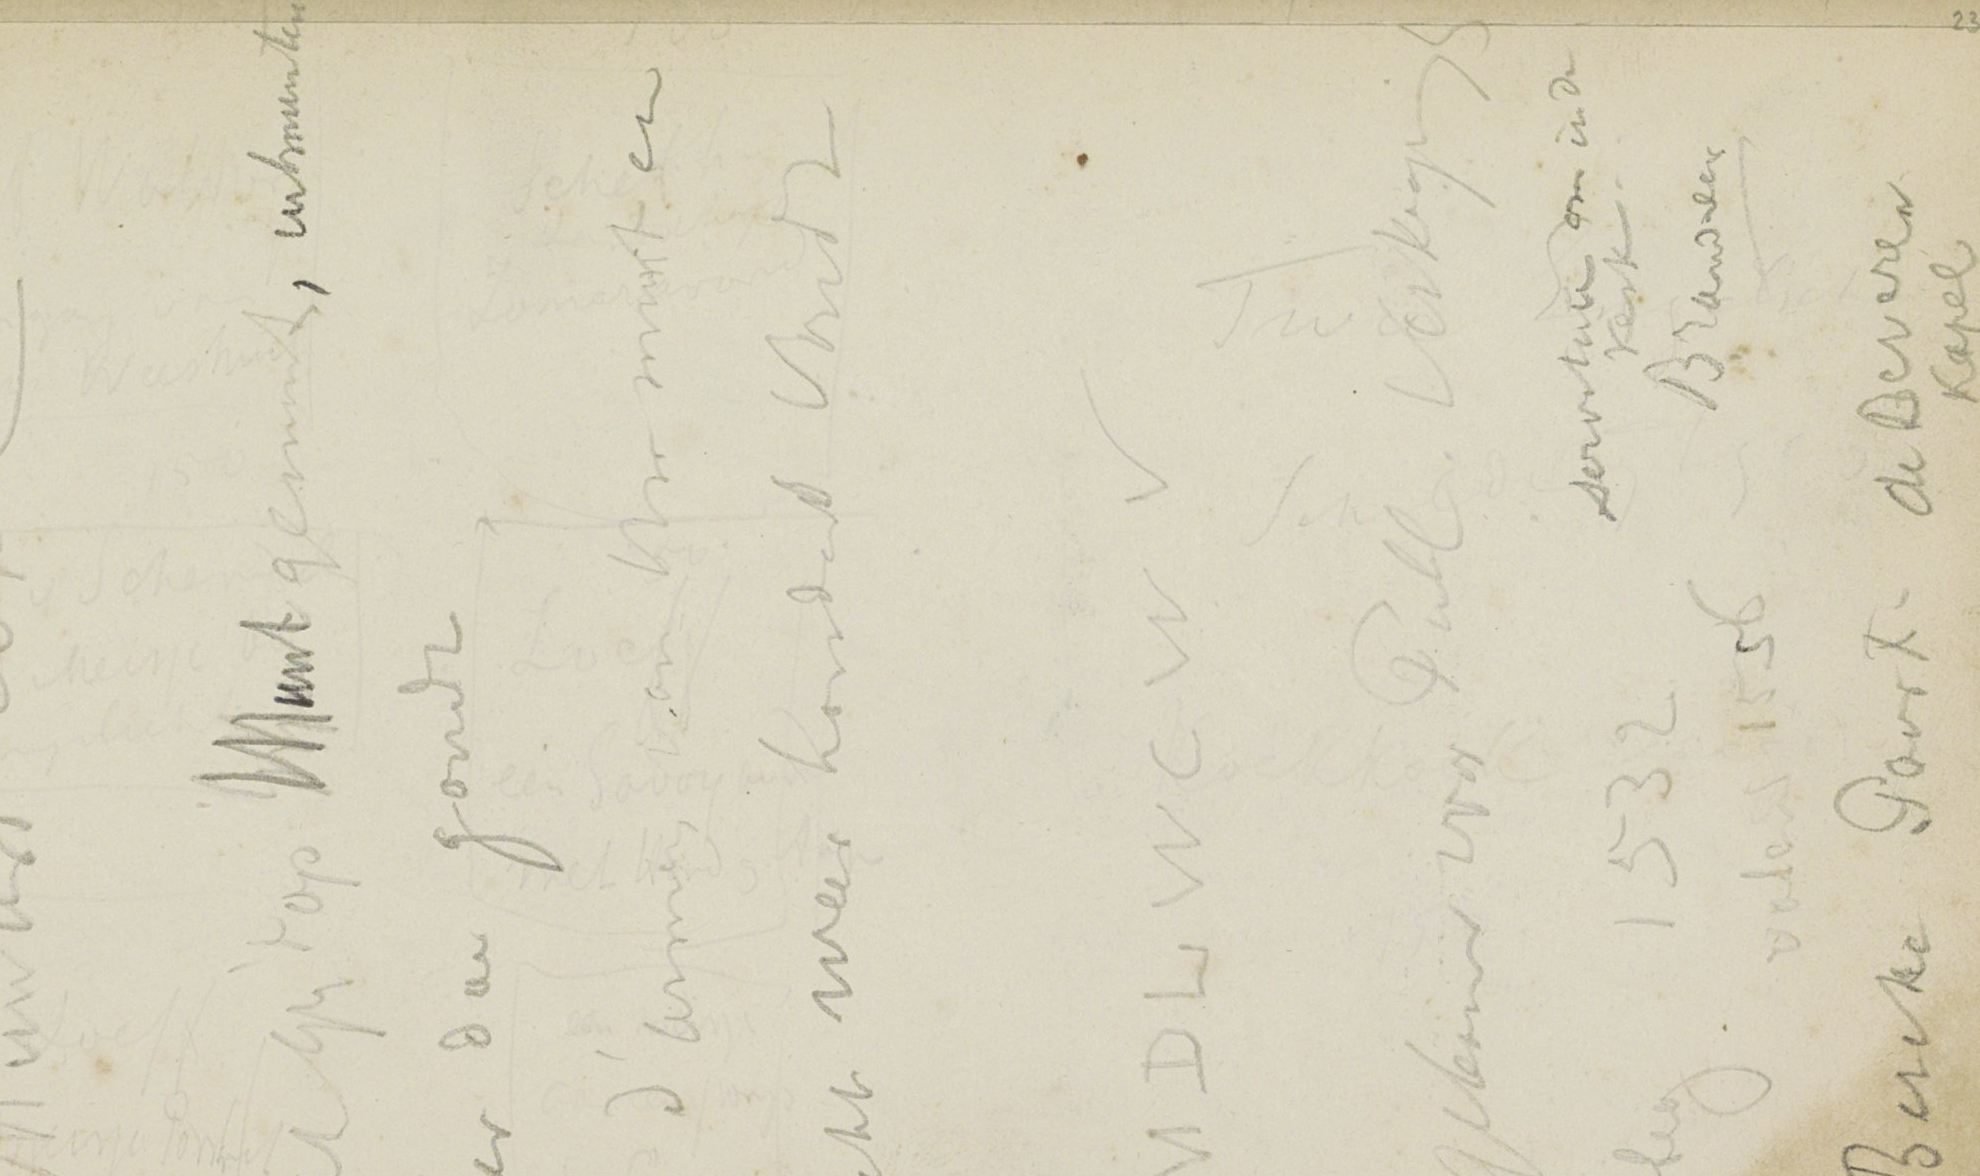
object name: sketchbook leaf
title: Notities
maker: johannes bosboom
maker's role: draughtsman, painter, print maker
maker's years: 1817-1891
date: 1845-1891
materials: paper, pencil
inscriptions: annotation: ‘munten cope[...]/ Hebt gij 't op Munt gemunt, uitmunten/ der dan ginder/ Deel [...] van [...] munt en/ macht meer [...] vond/ MDLWCWV/ gete[...] voor [...] verkr[...]/ beg 1532 [...]/ [...] 1556/ Bercke Poort de Bever Kapel’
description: Blad 23 recto uit een schetsboek met 46 bladen.